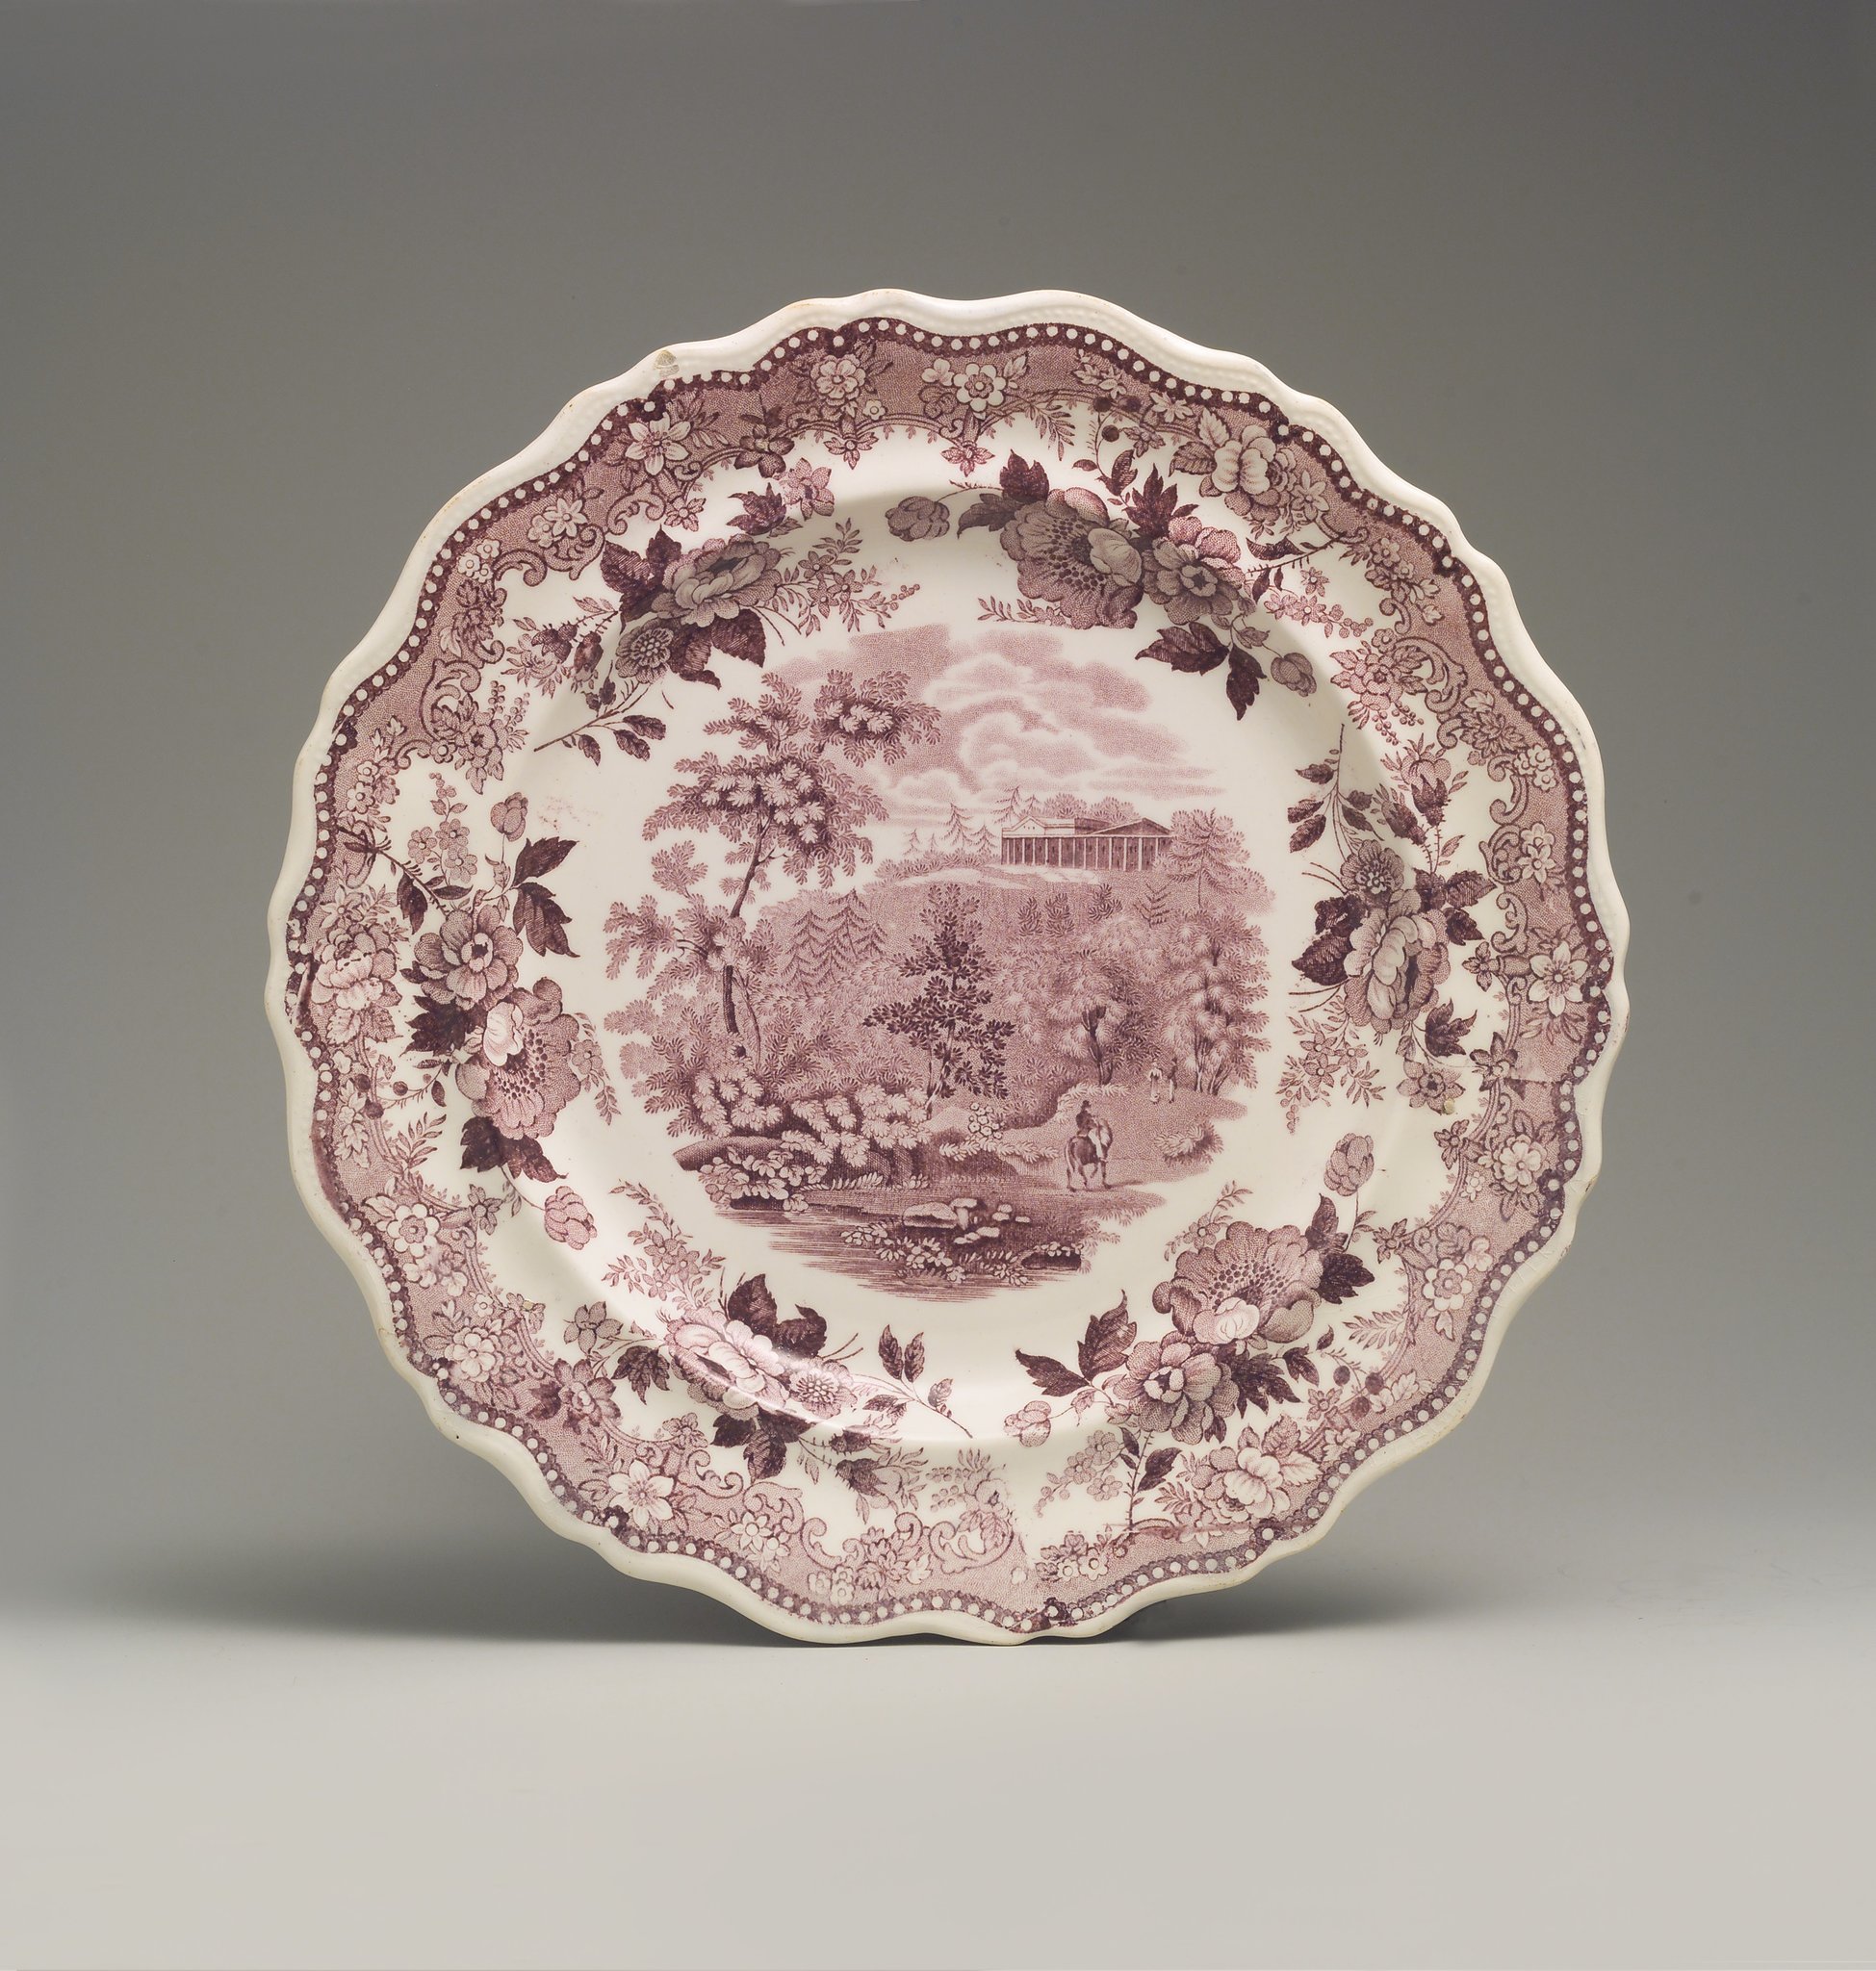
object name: plate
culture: british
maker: job & john jackson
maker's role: maker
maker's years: 1831-1835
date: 1831-1835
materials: earthenware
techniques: transfer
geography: england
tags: flowers,landscapes